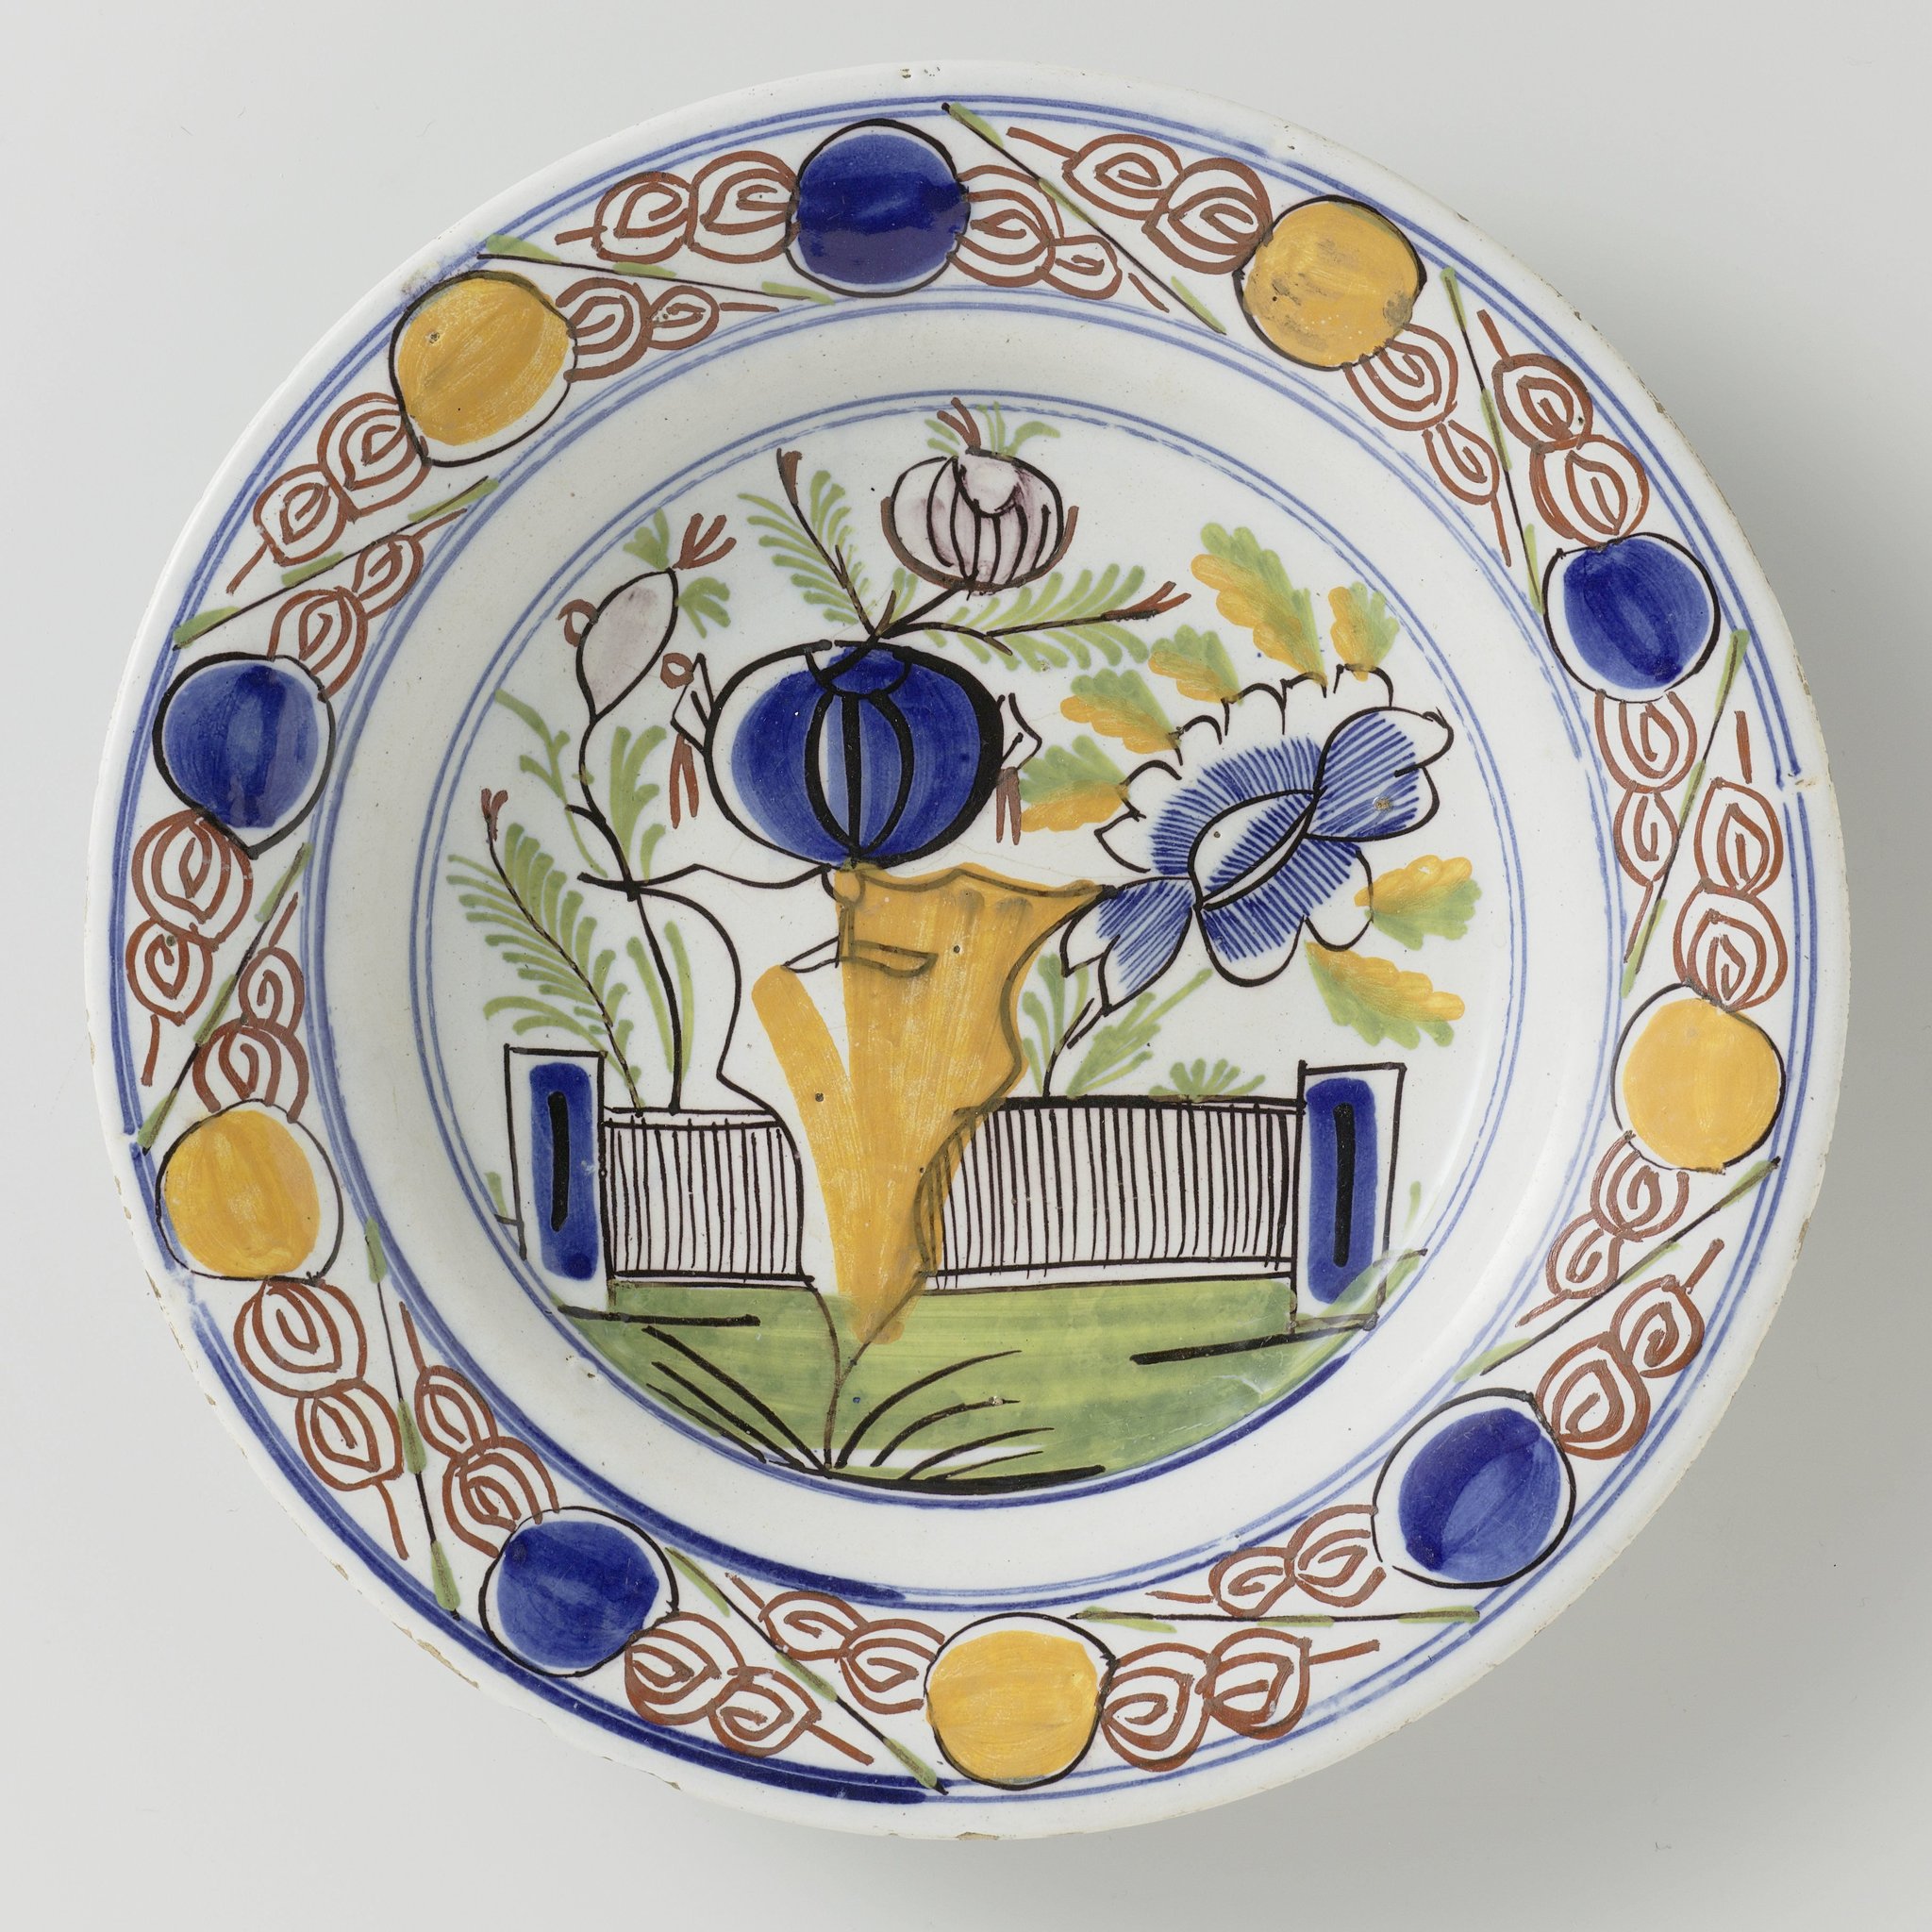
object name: plate dish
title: Bord van veelkleurig beschilderde faience met bloemdecoratie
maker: Anonymous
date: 1750-1790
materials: faience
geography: delft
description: Bord van veelkleurig beschilderde faience, versierd met bloemen in blauw, oranje, groen, rood en paars op witte grond.